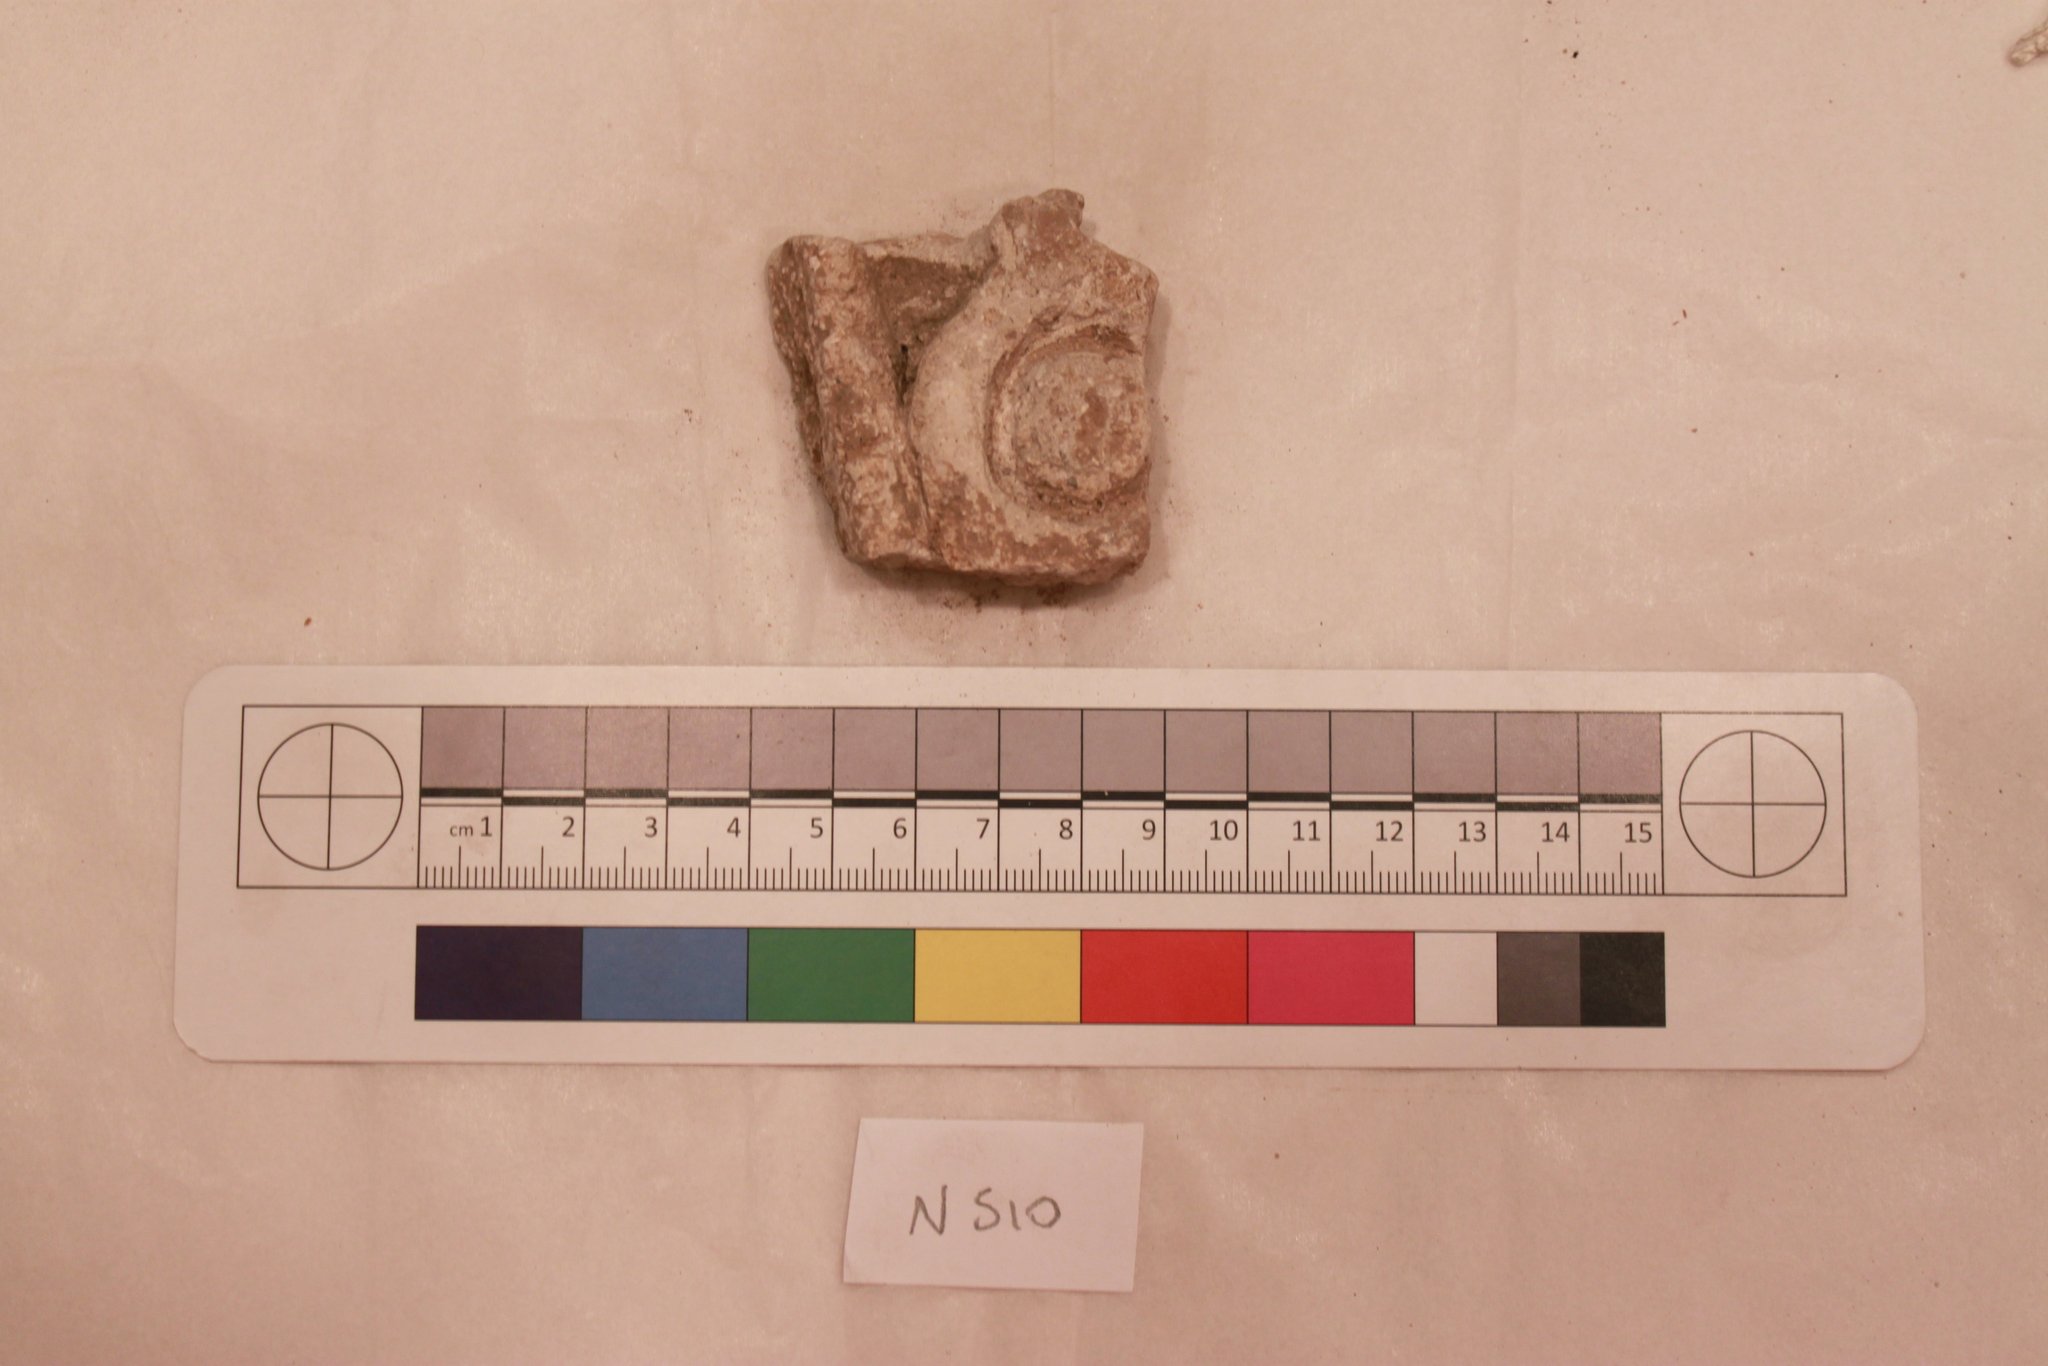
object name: fragment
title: Stucco Fragment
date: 701-1200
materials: plaster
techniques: carving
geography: iran